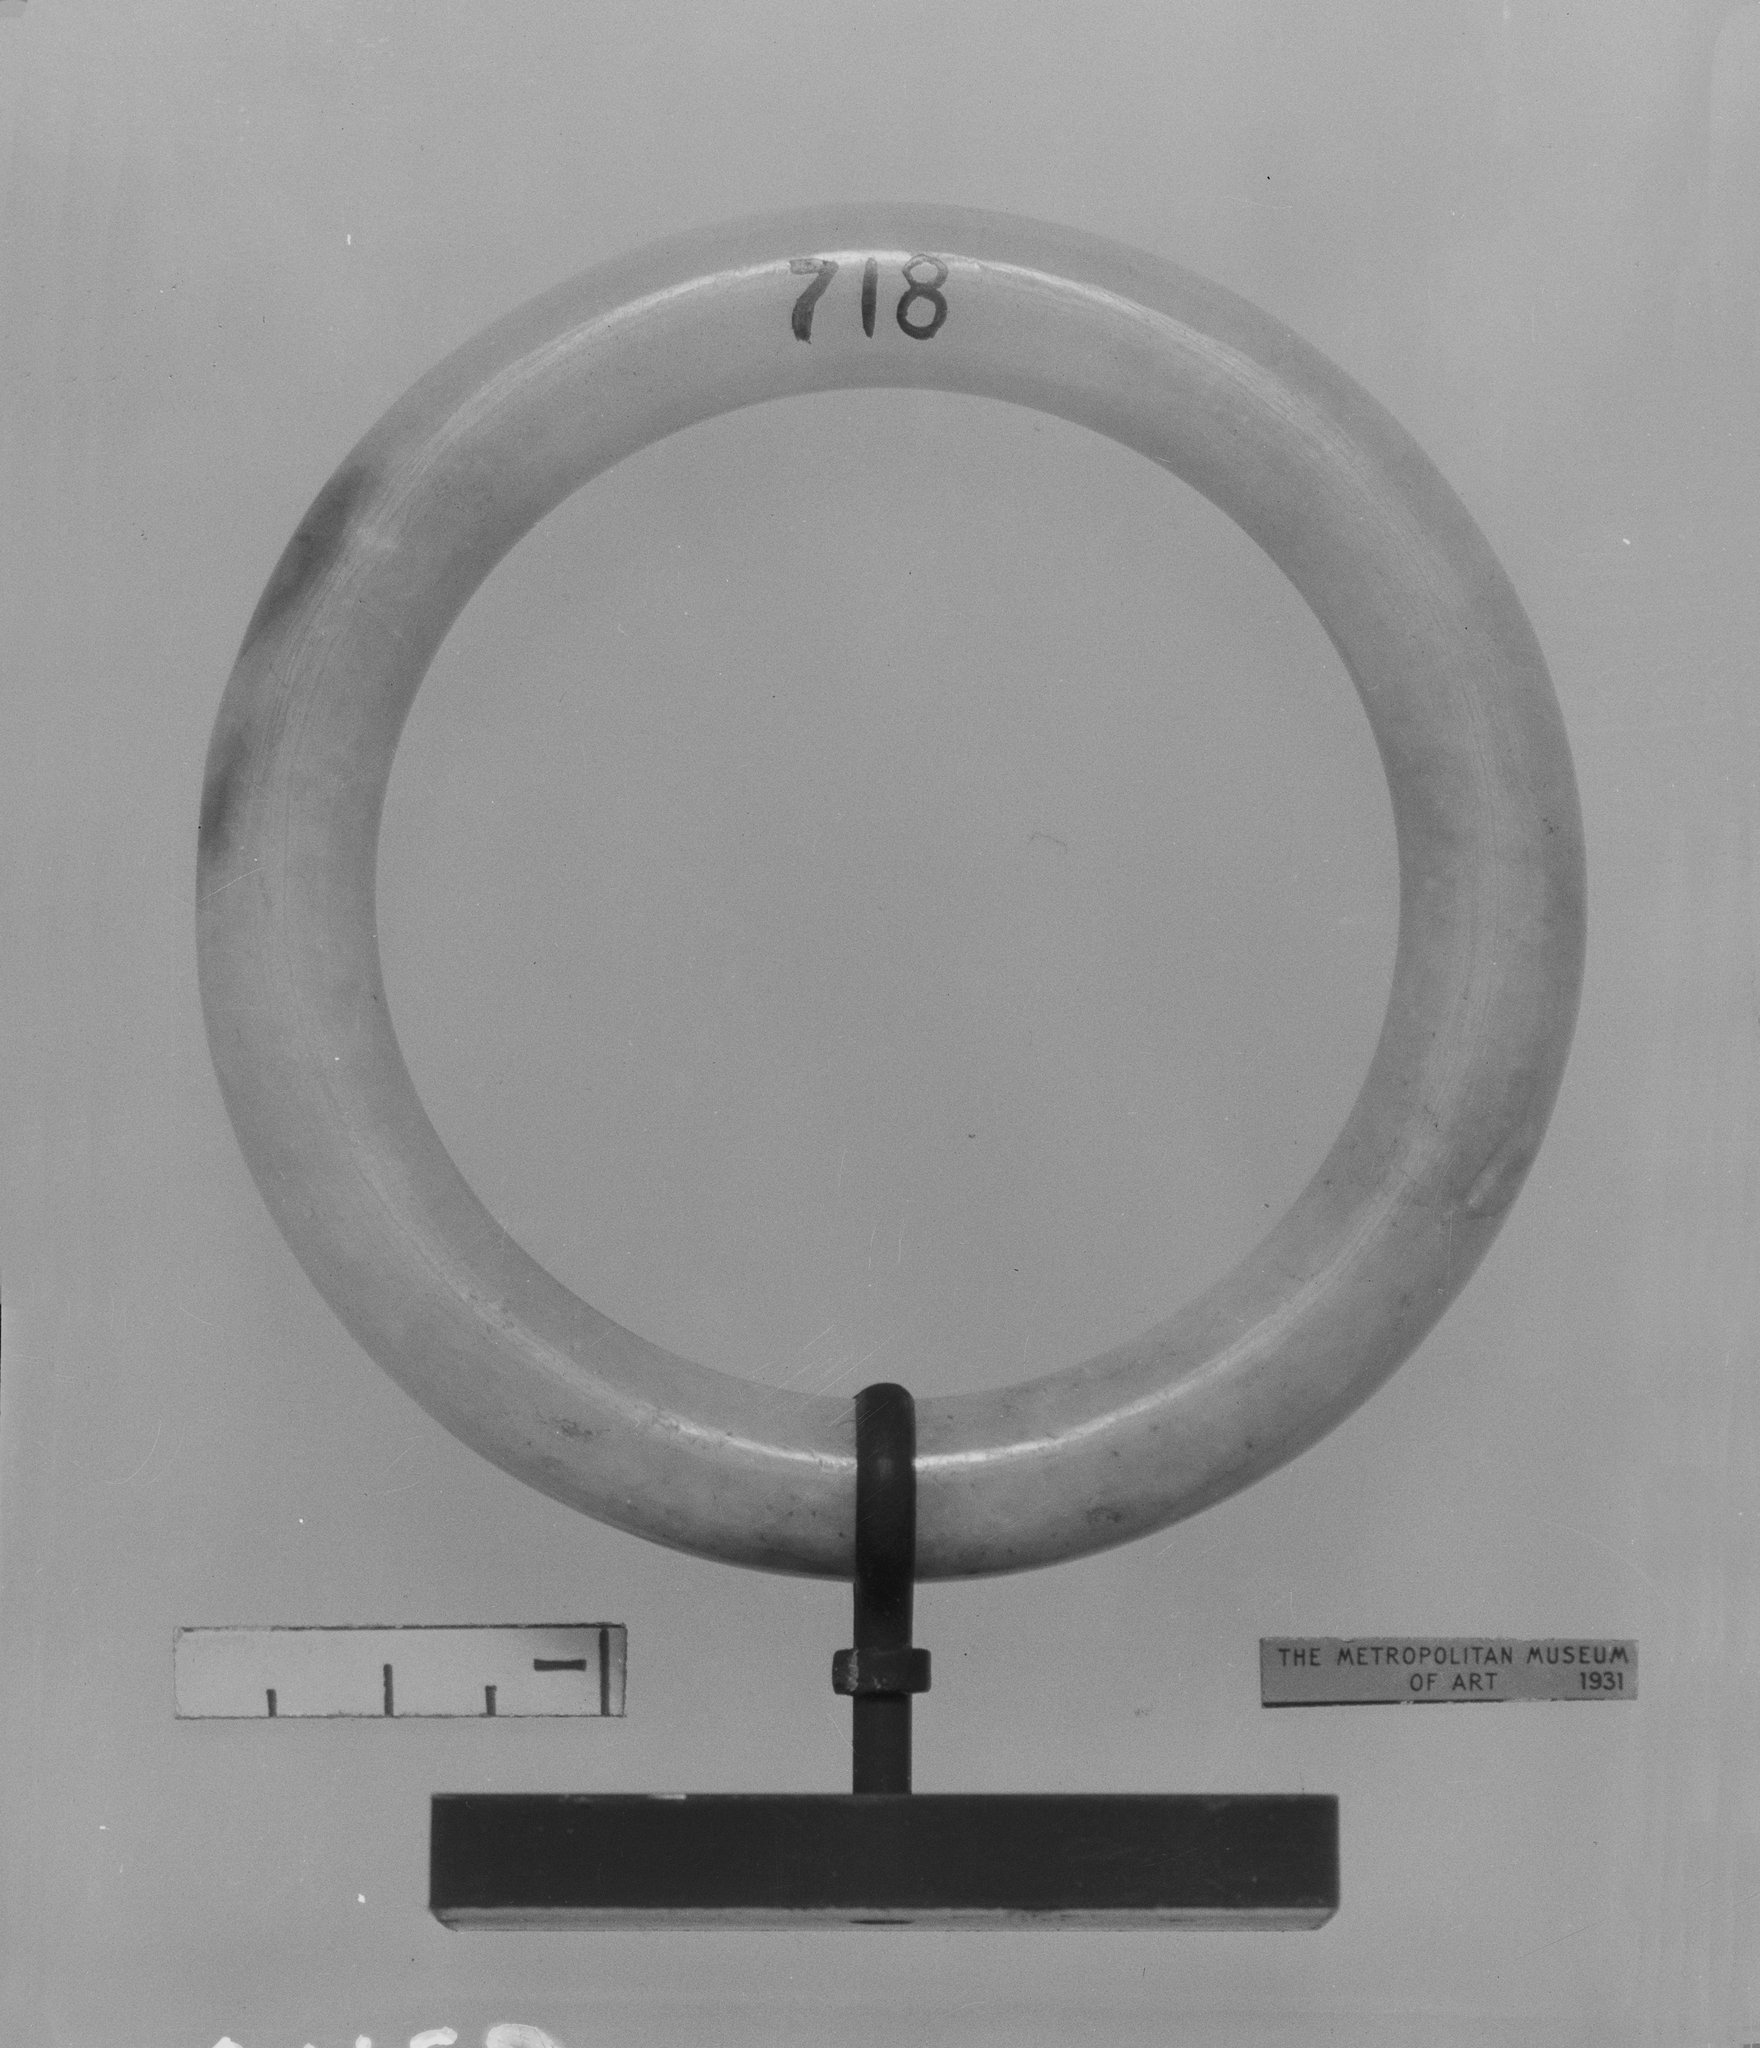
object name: armlet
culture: chinese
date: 1796-1875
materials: jade